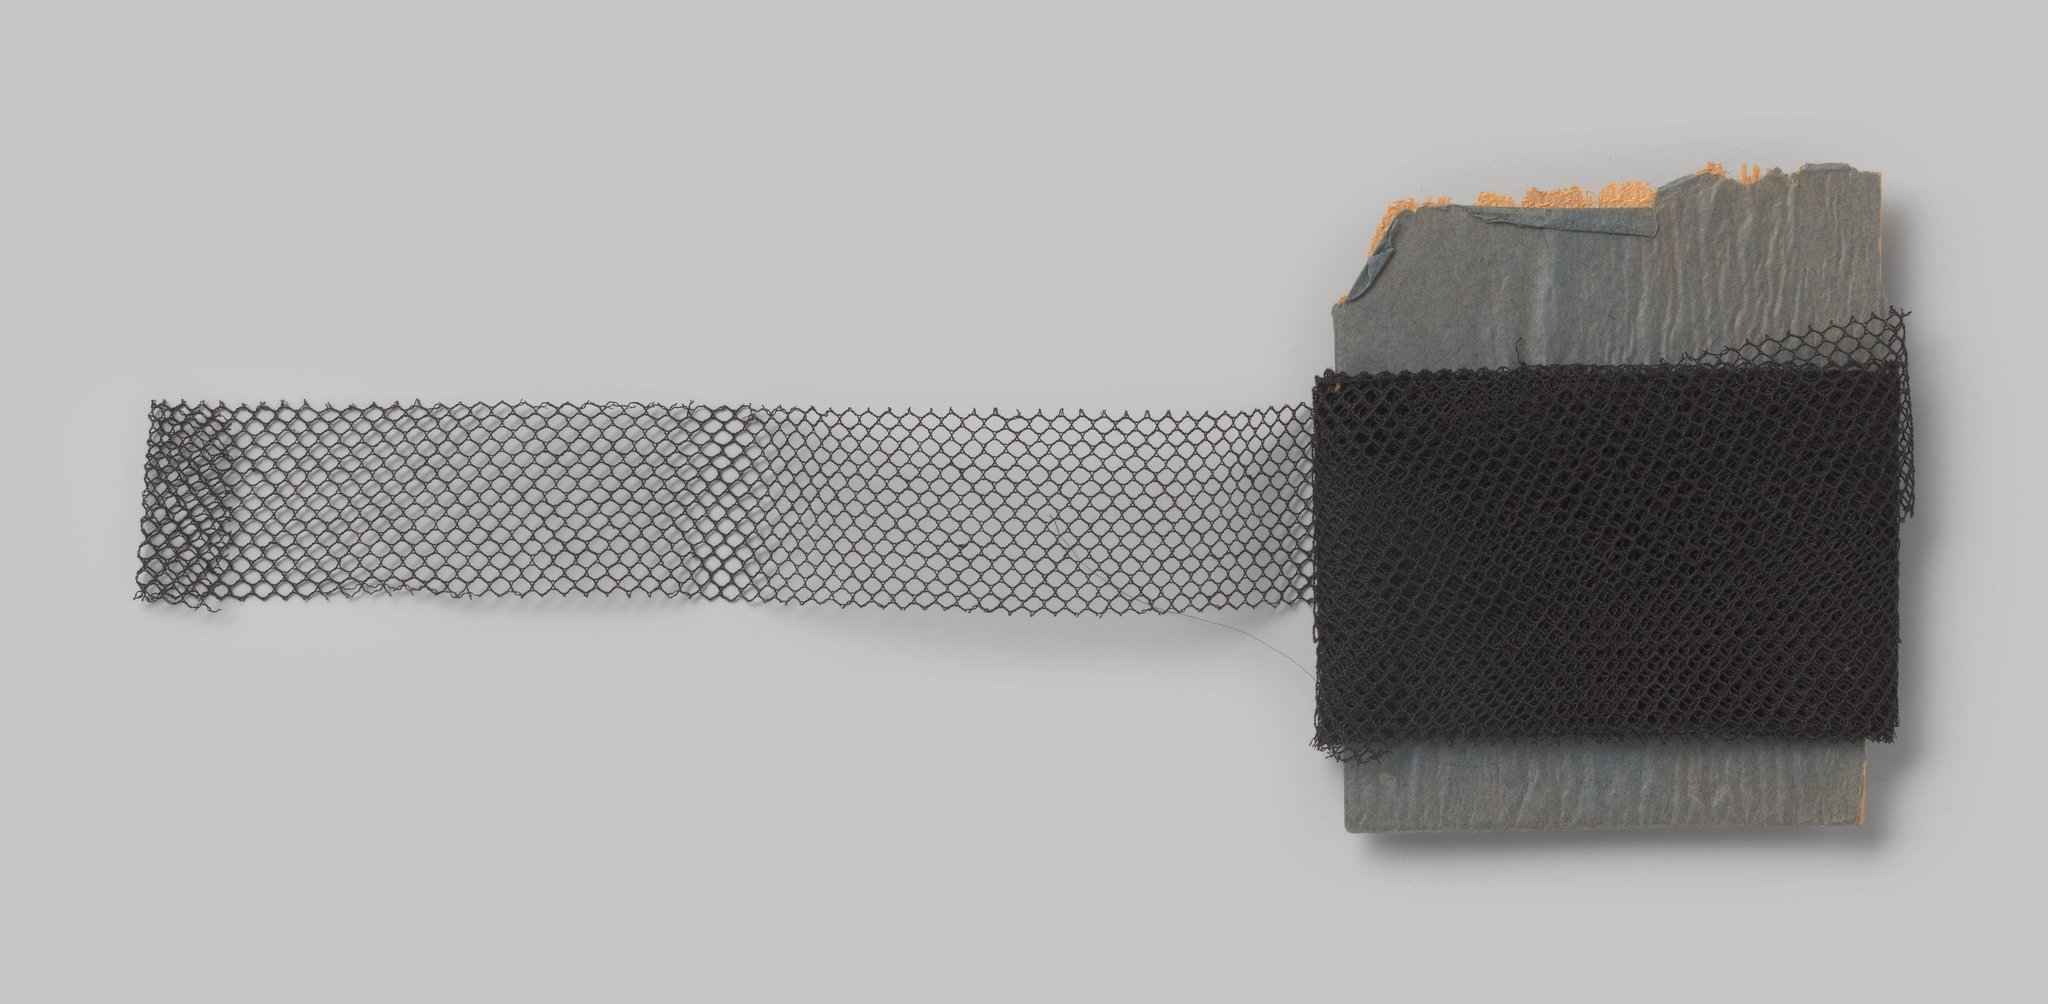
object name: braid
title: Hout waarop een zwart lint van zijden tule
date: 1900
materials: silk, wood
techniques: weave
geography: nijmegen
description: Hout waarop een zwart lint van zijden tule.